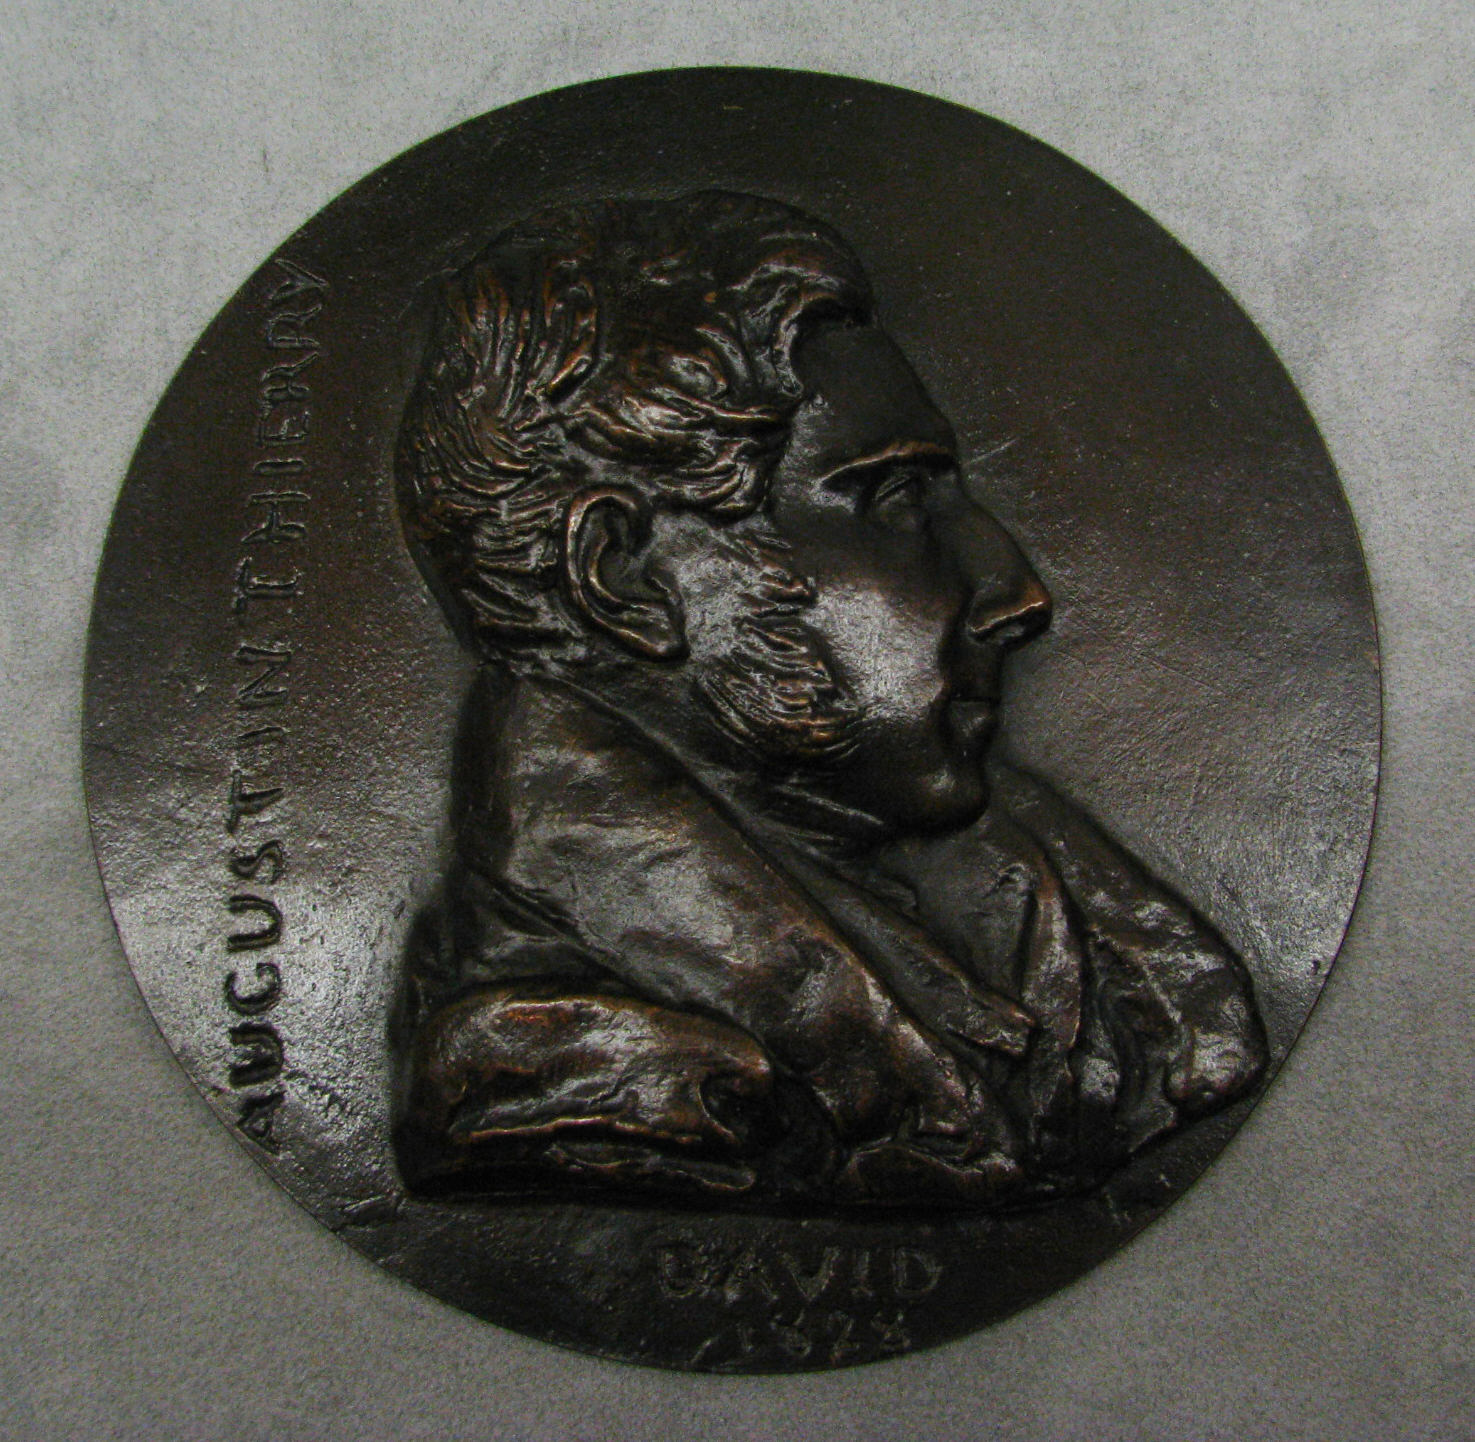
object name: medallion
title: Augustin Thierry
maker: pierre jean david d'angers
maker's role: maker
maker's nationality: french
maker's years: 1788-1856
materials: bronze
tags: men,profiles